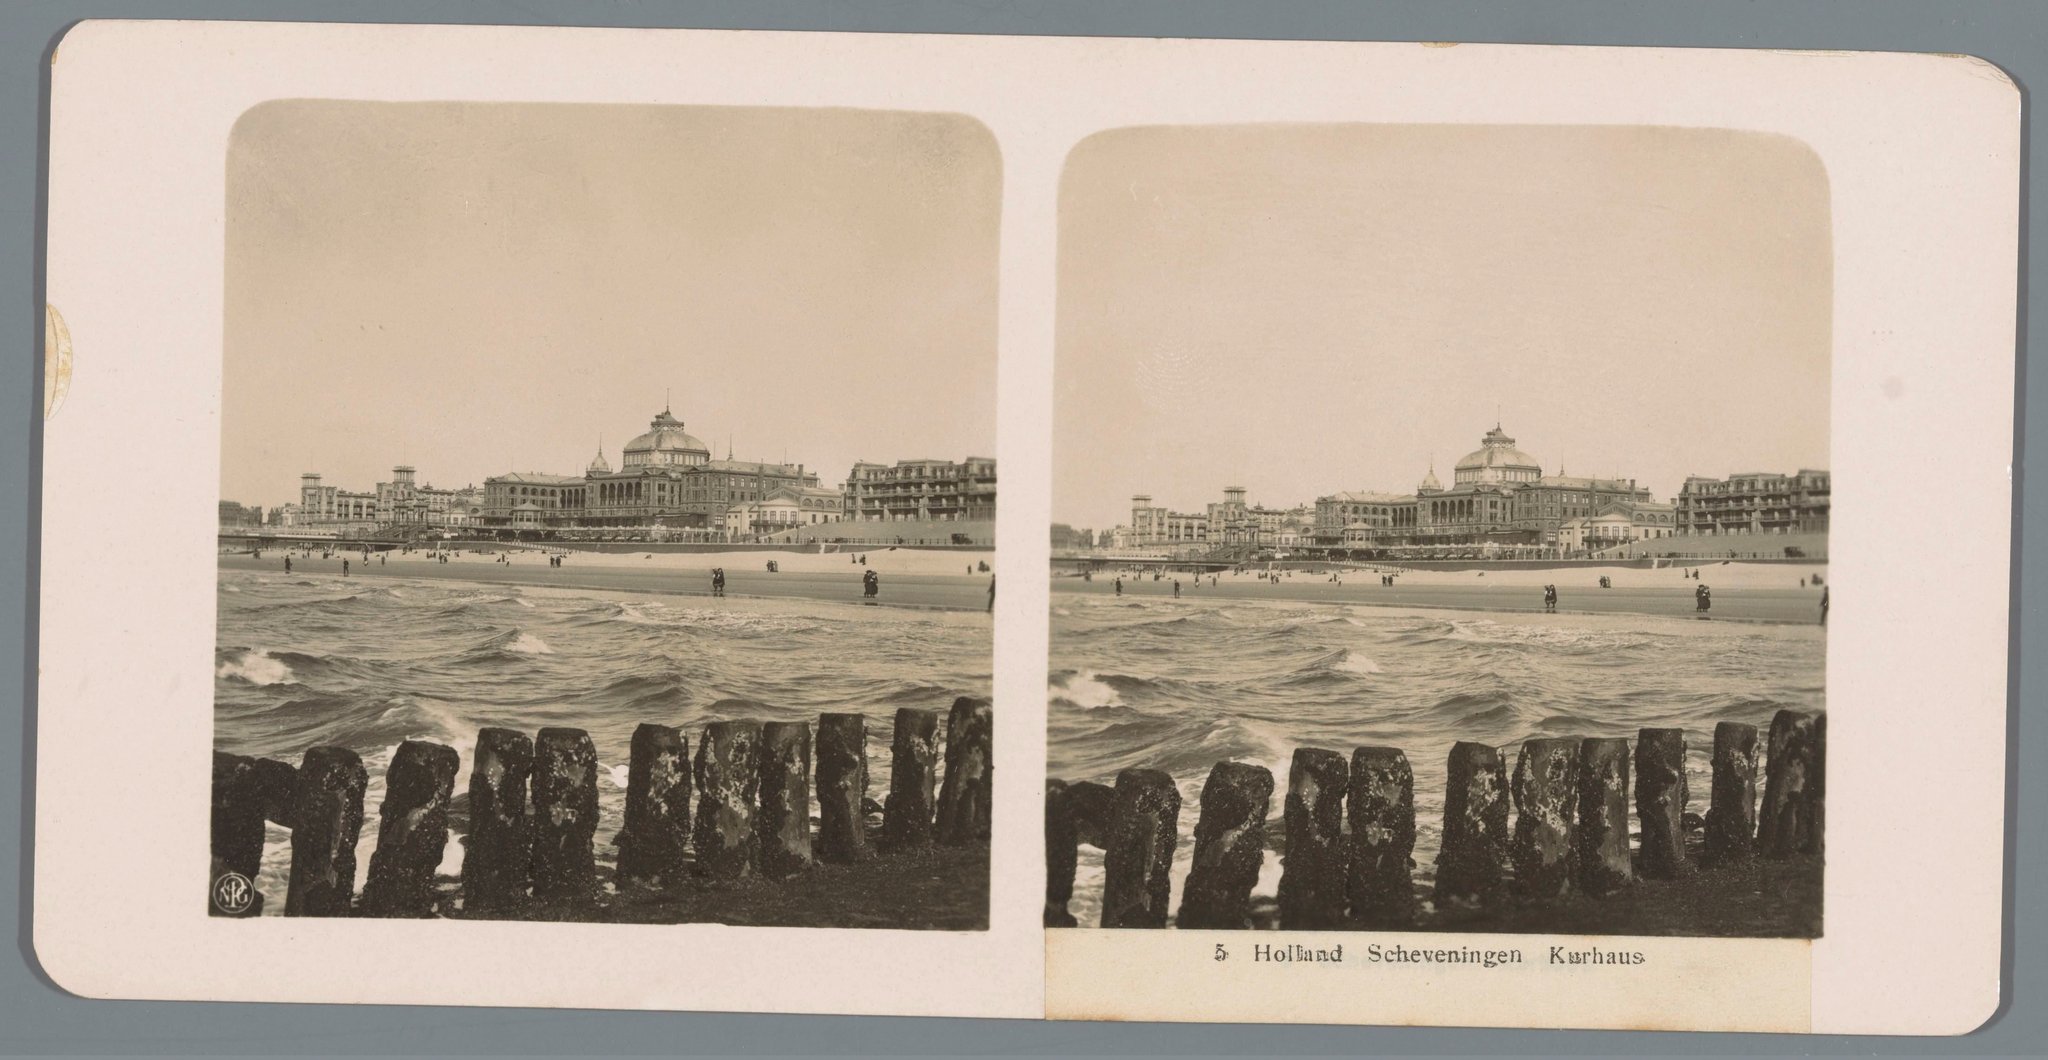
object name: stereograph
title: Holland Scheveningen Kurhaus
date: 1900-1910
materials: cardboard, photographic support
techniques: gelatin silver print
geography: scheveningen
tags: coastal protection work, breakwater, façade (of house or building), hotel, hostelry, inn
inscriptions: number: ‘5’, inscription: ‘NPG’